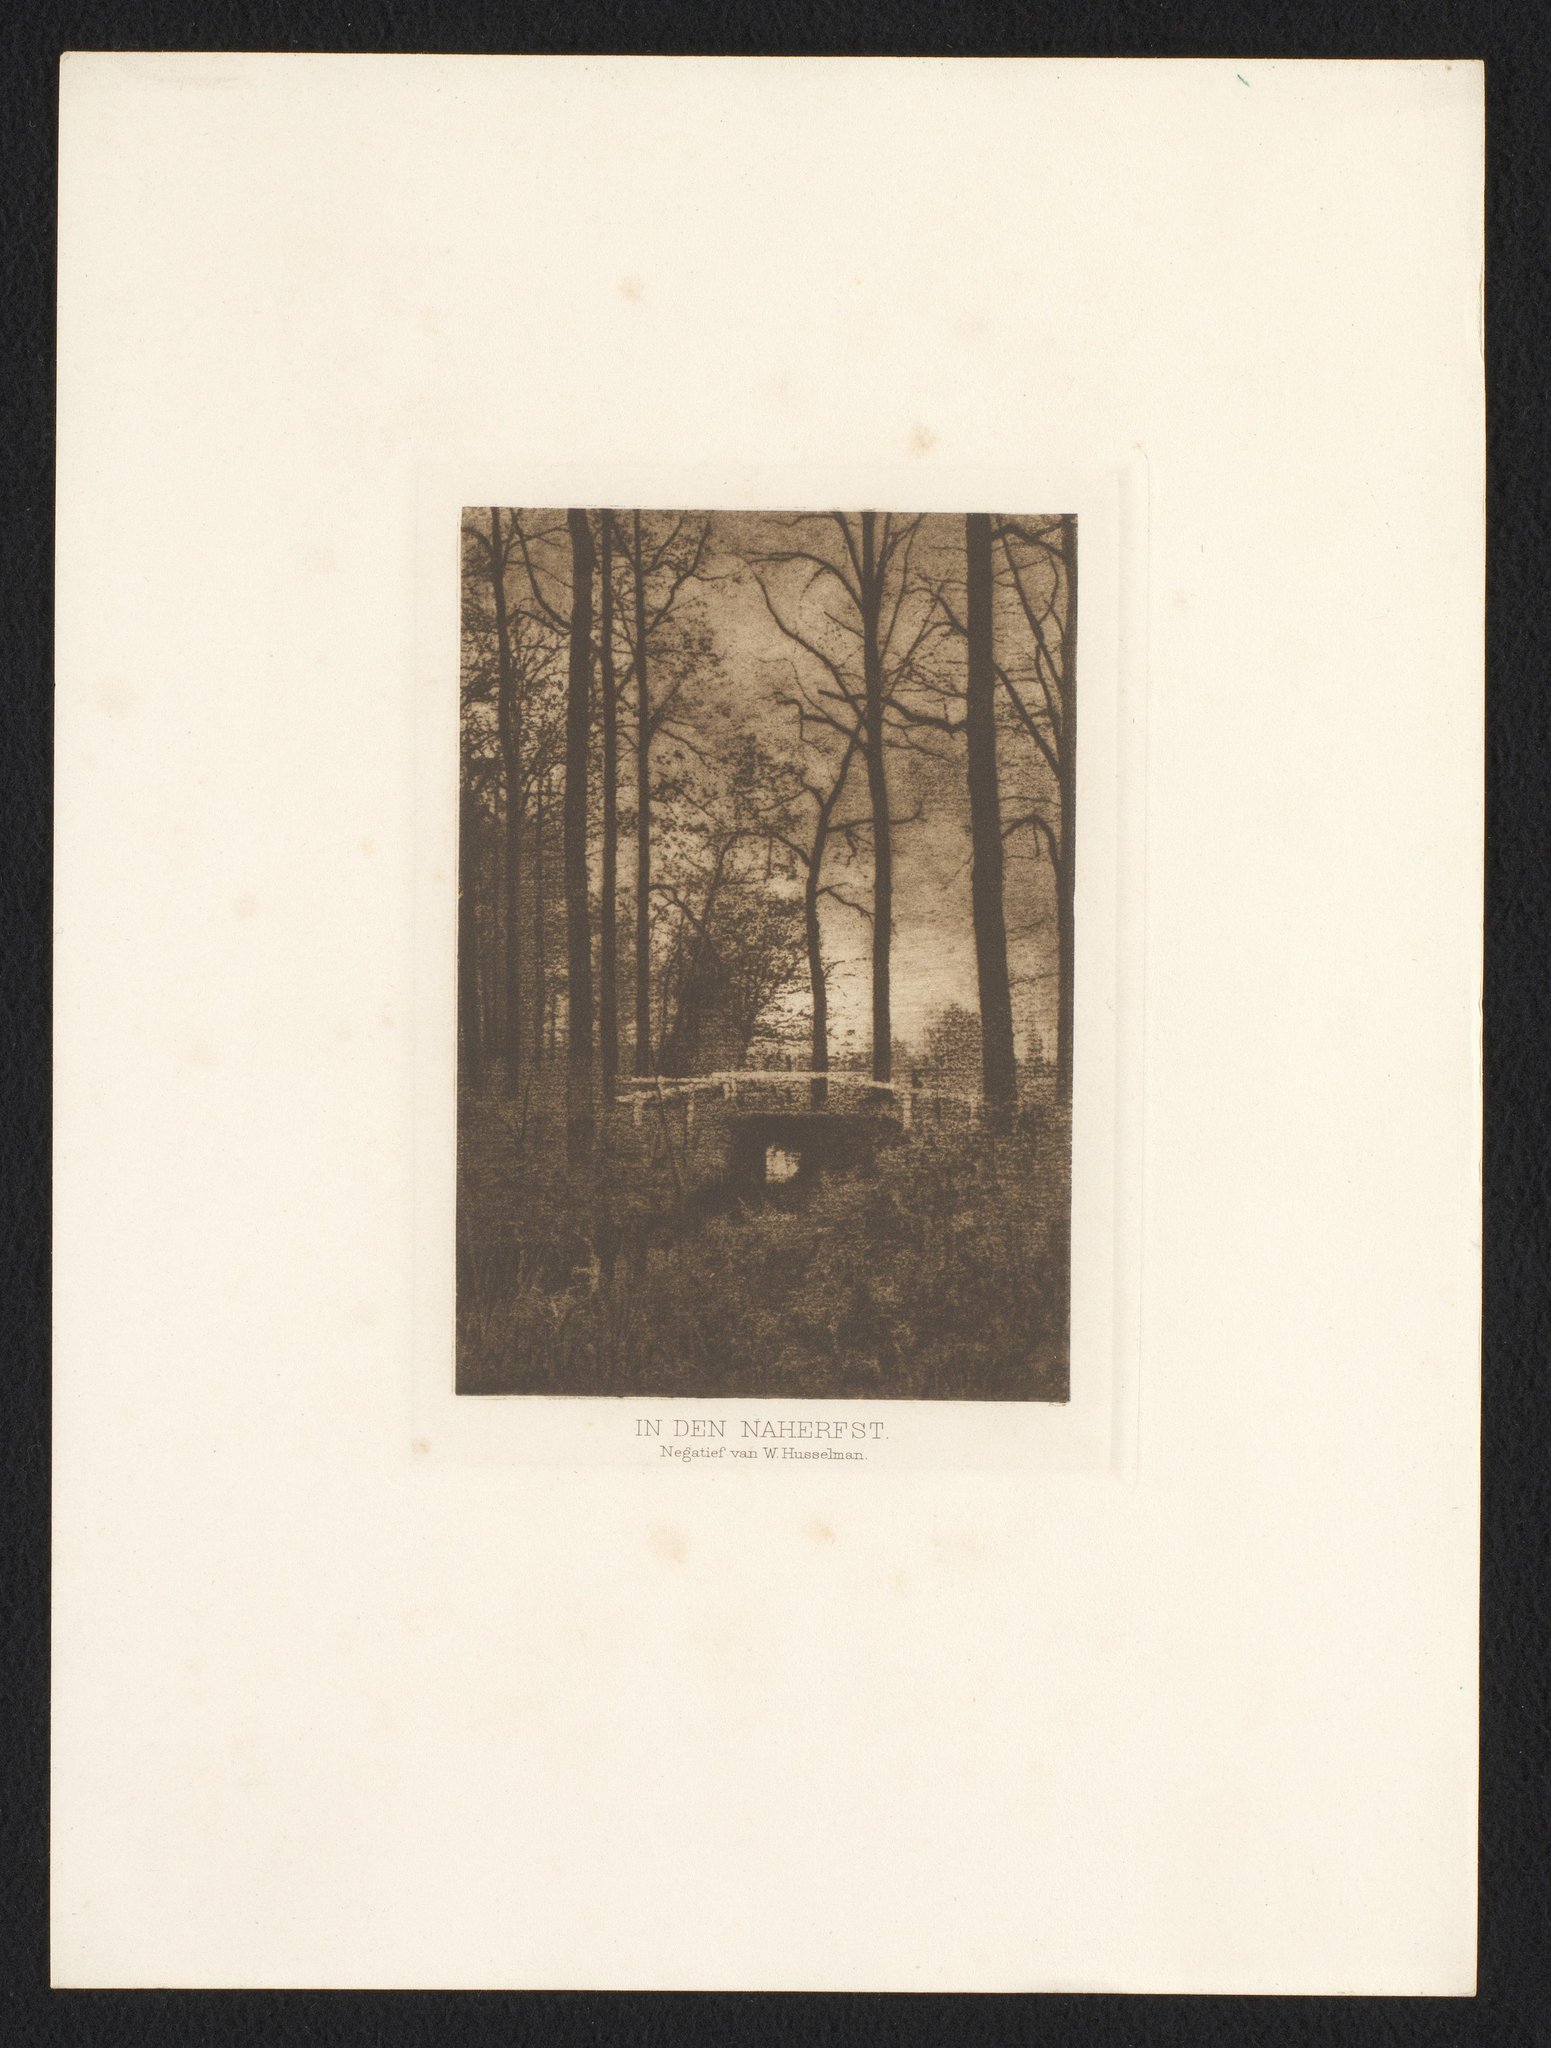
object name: page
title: In den naherfst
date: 1899-1904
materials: paper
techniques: photoaquatint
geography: netherlands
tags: trees, landscape with bridge, viaduct or aqueduct, forest, wood